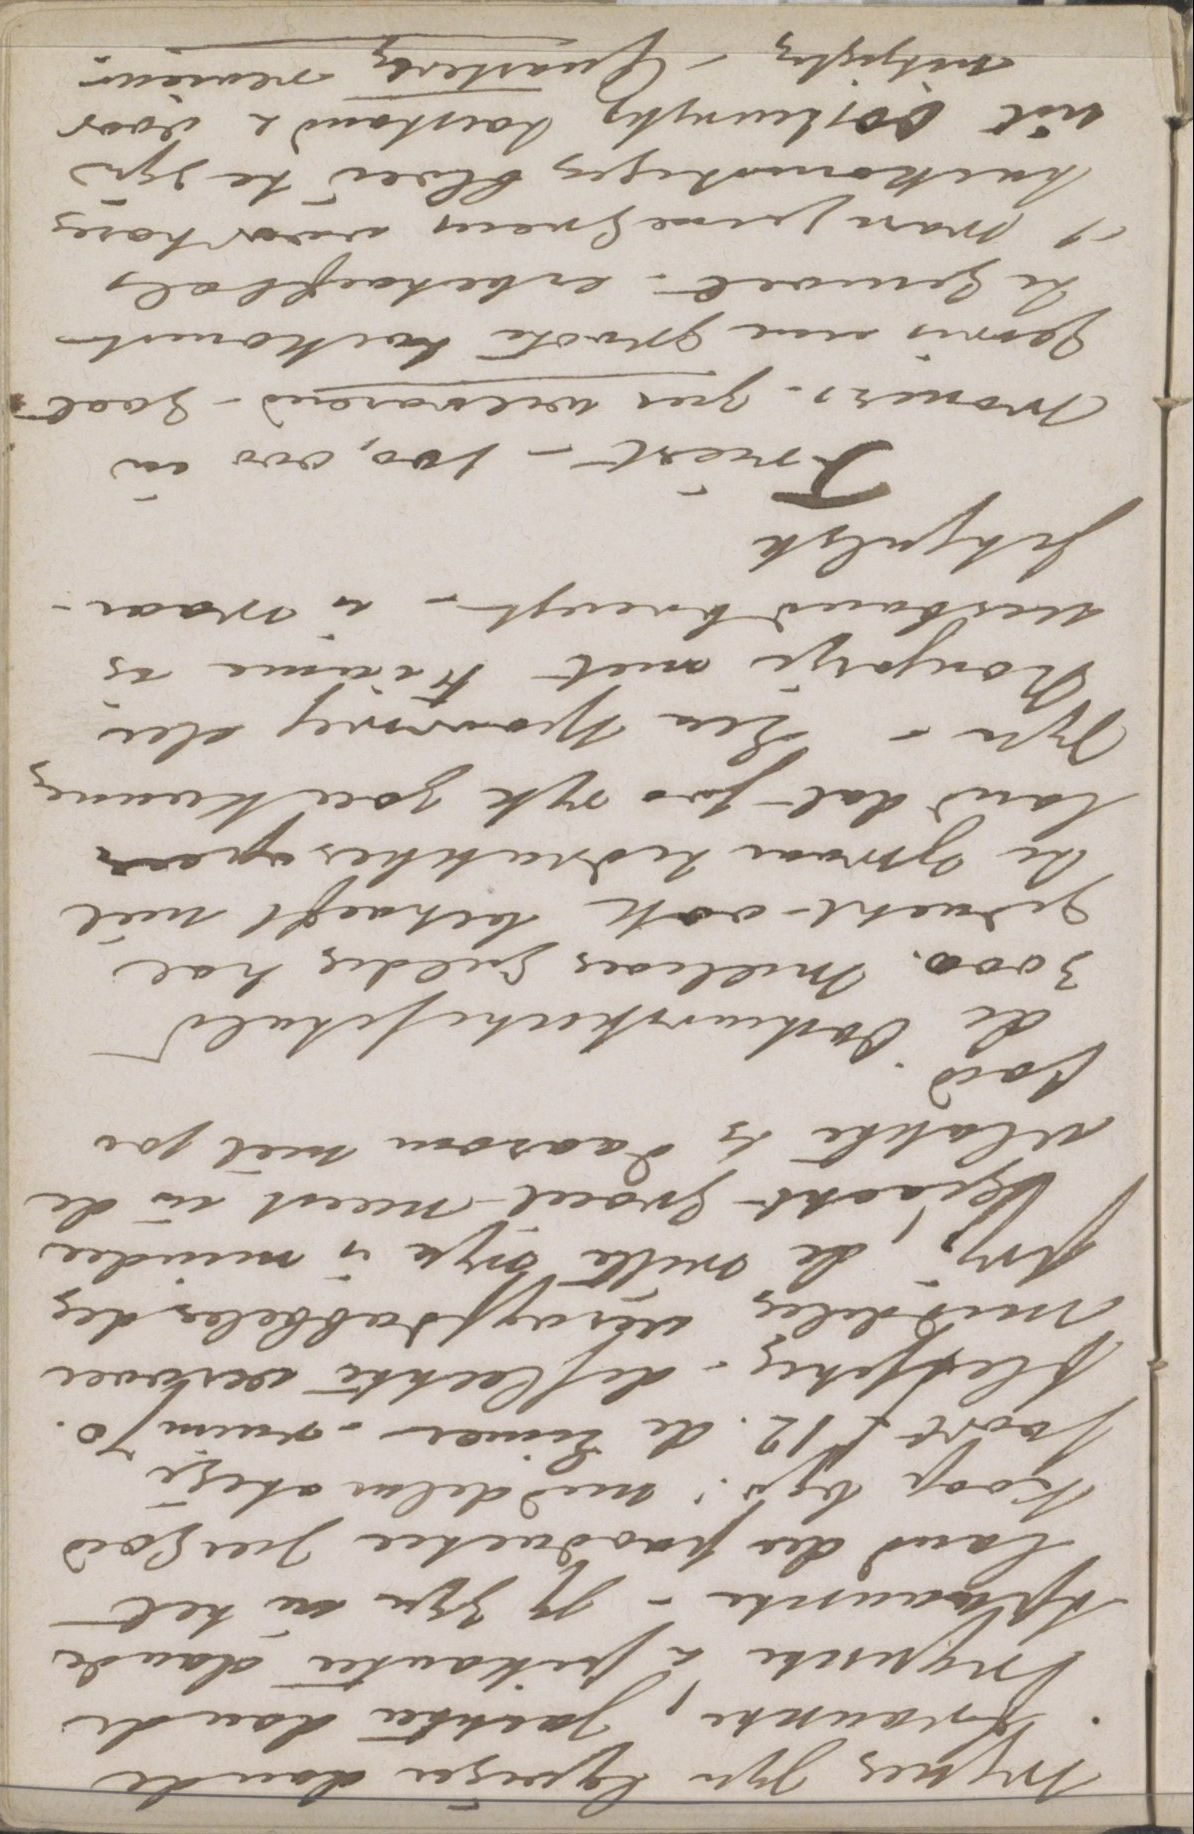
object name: sketchbook leaf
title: Deel van een artikel over Hongarije gekopieerd uit de 'Quarterly Review'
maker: johannes tavenraat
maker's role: draughtsman, painter, print maker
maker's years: 1809-1881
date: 1862-1864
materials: ink, paper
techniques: pen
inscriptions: annotation: ‘[...]’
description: Blad 52 verso uit een schetsboek met 65 bladen.